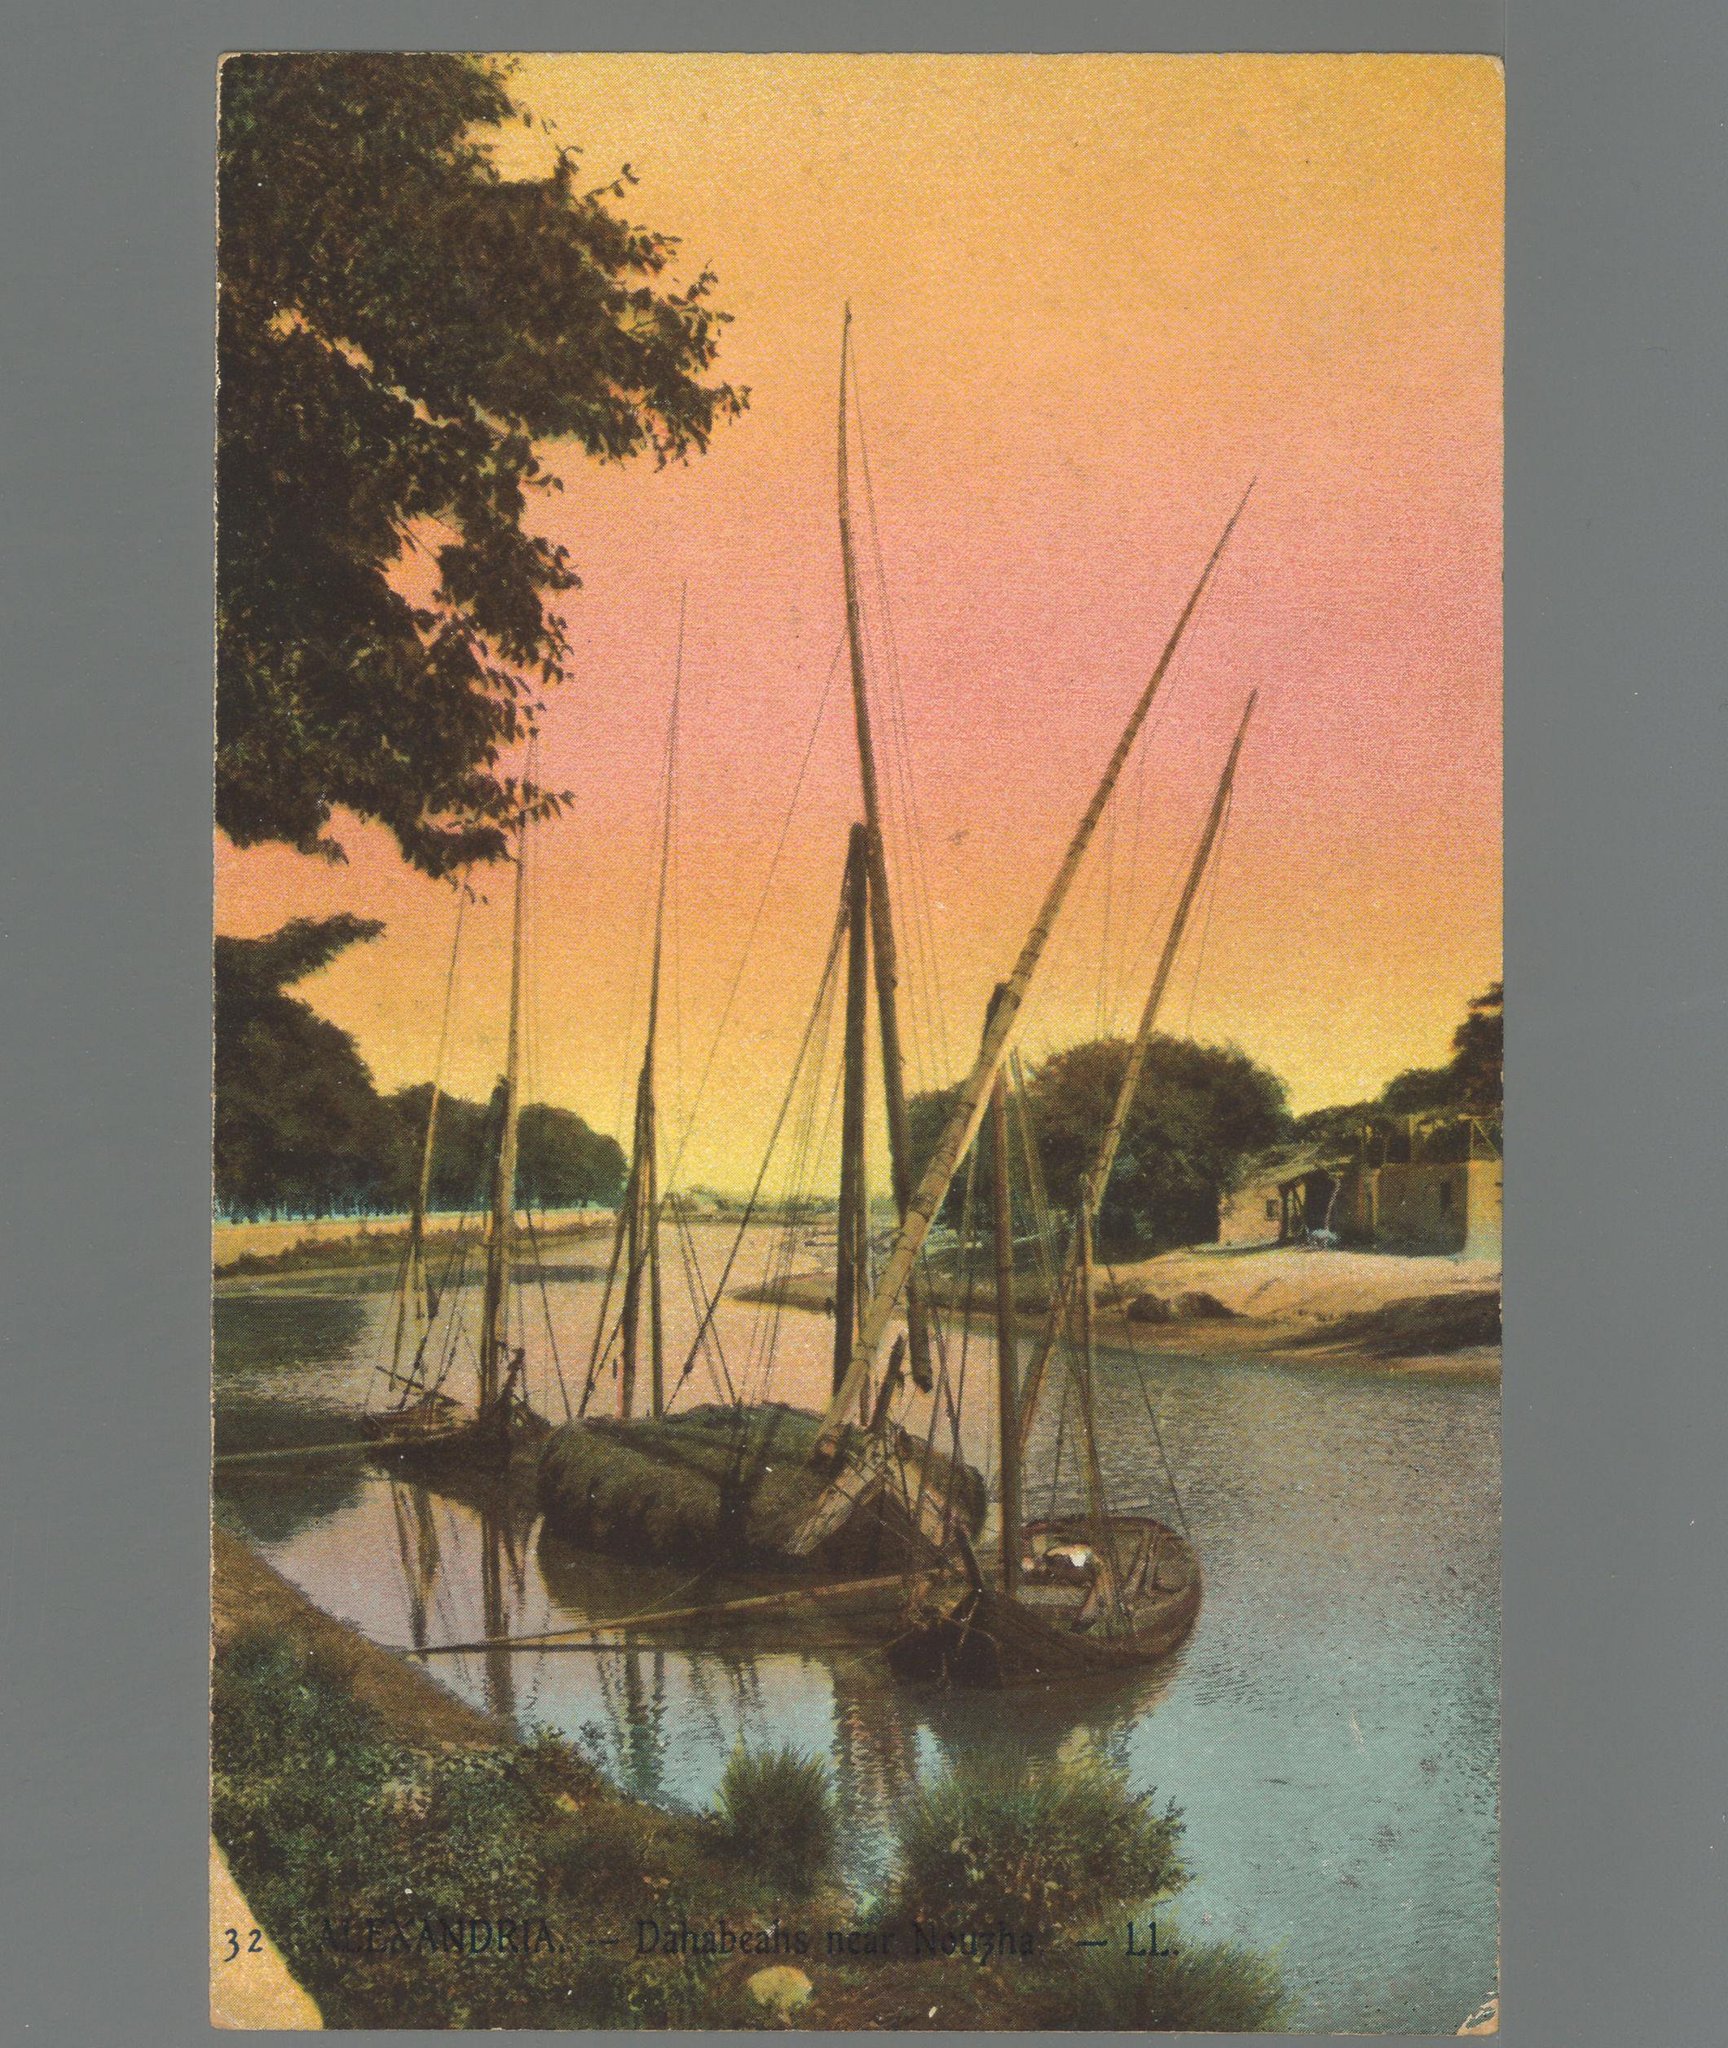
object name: ansichtkaart, prentbriefkaart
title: Alexandria - Dahabeahs near Nouzha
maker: Anonymous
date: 1907-1909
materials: cardboard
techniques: lithograph, writing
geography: alexandria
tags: sailing-ship, sailing-boat, river